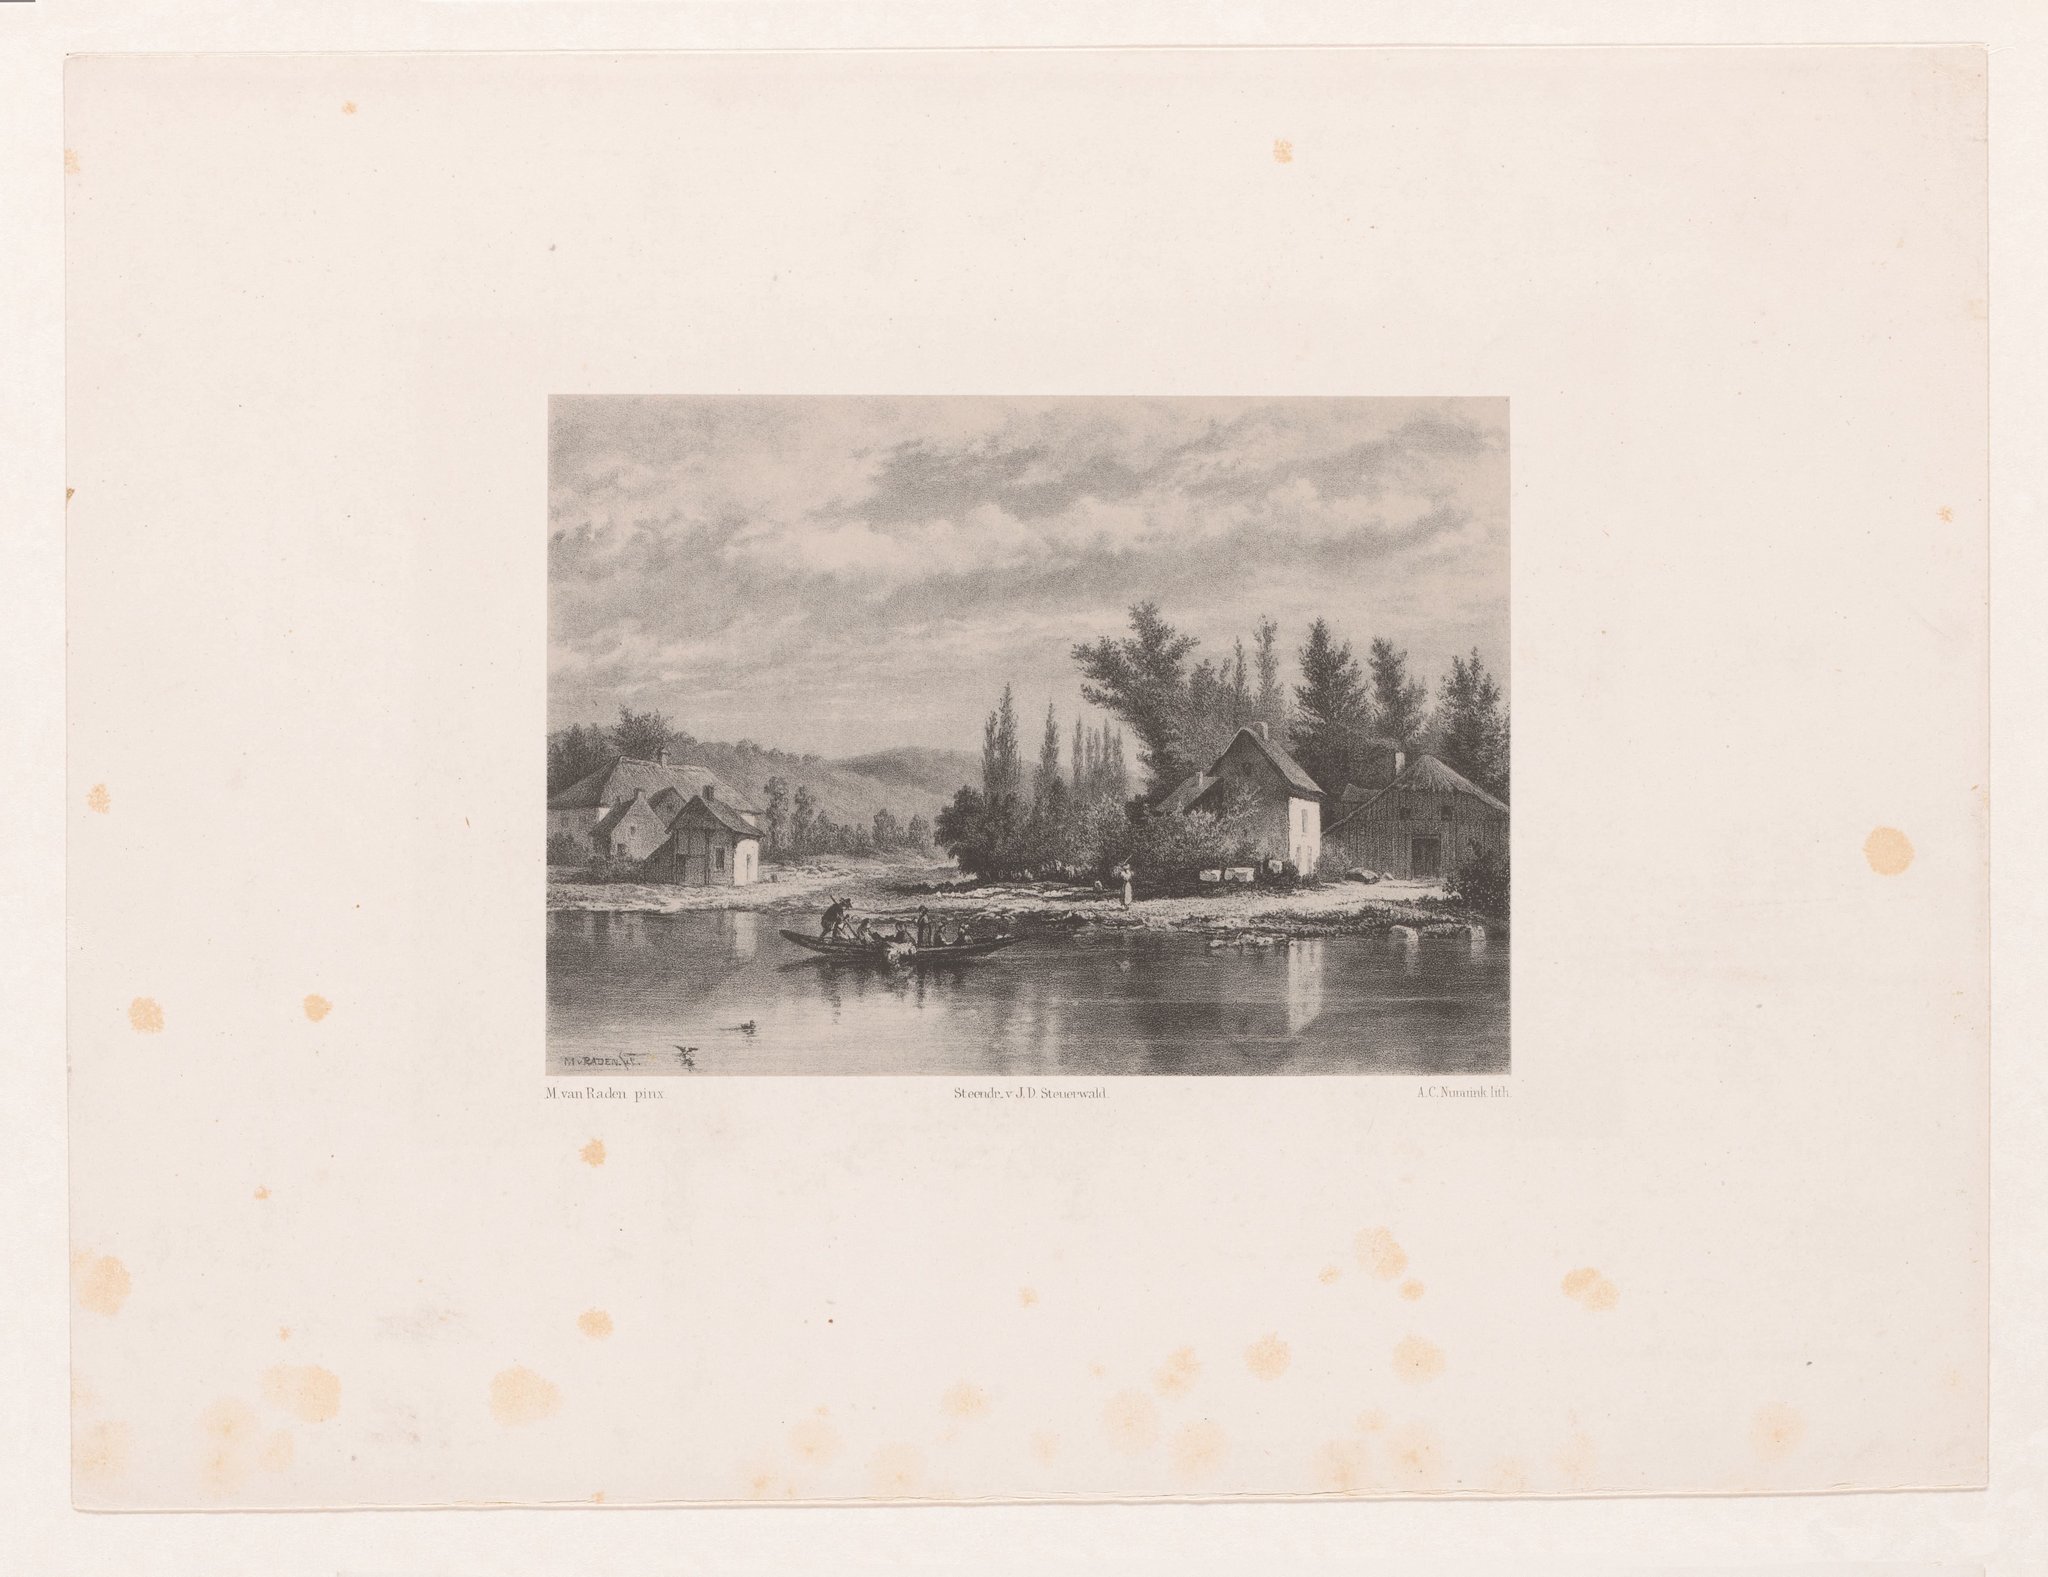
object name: print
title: Dorp aan oever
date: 1842-1863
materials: paper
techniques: lithograph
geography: the hague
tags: village, lake, boat propelled by man or animal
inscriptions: collector's mark: Lugt 2228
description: Enkele huizen en boerderijen aan de oever van een meer waarop figuren in een boot varen. In de achtergrond een heuvellandschap.